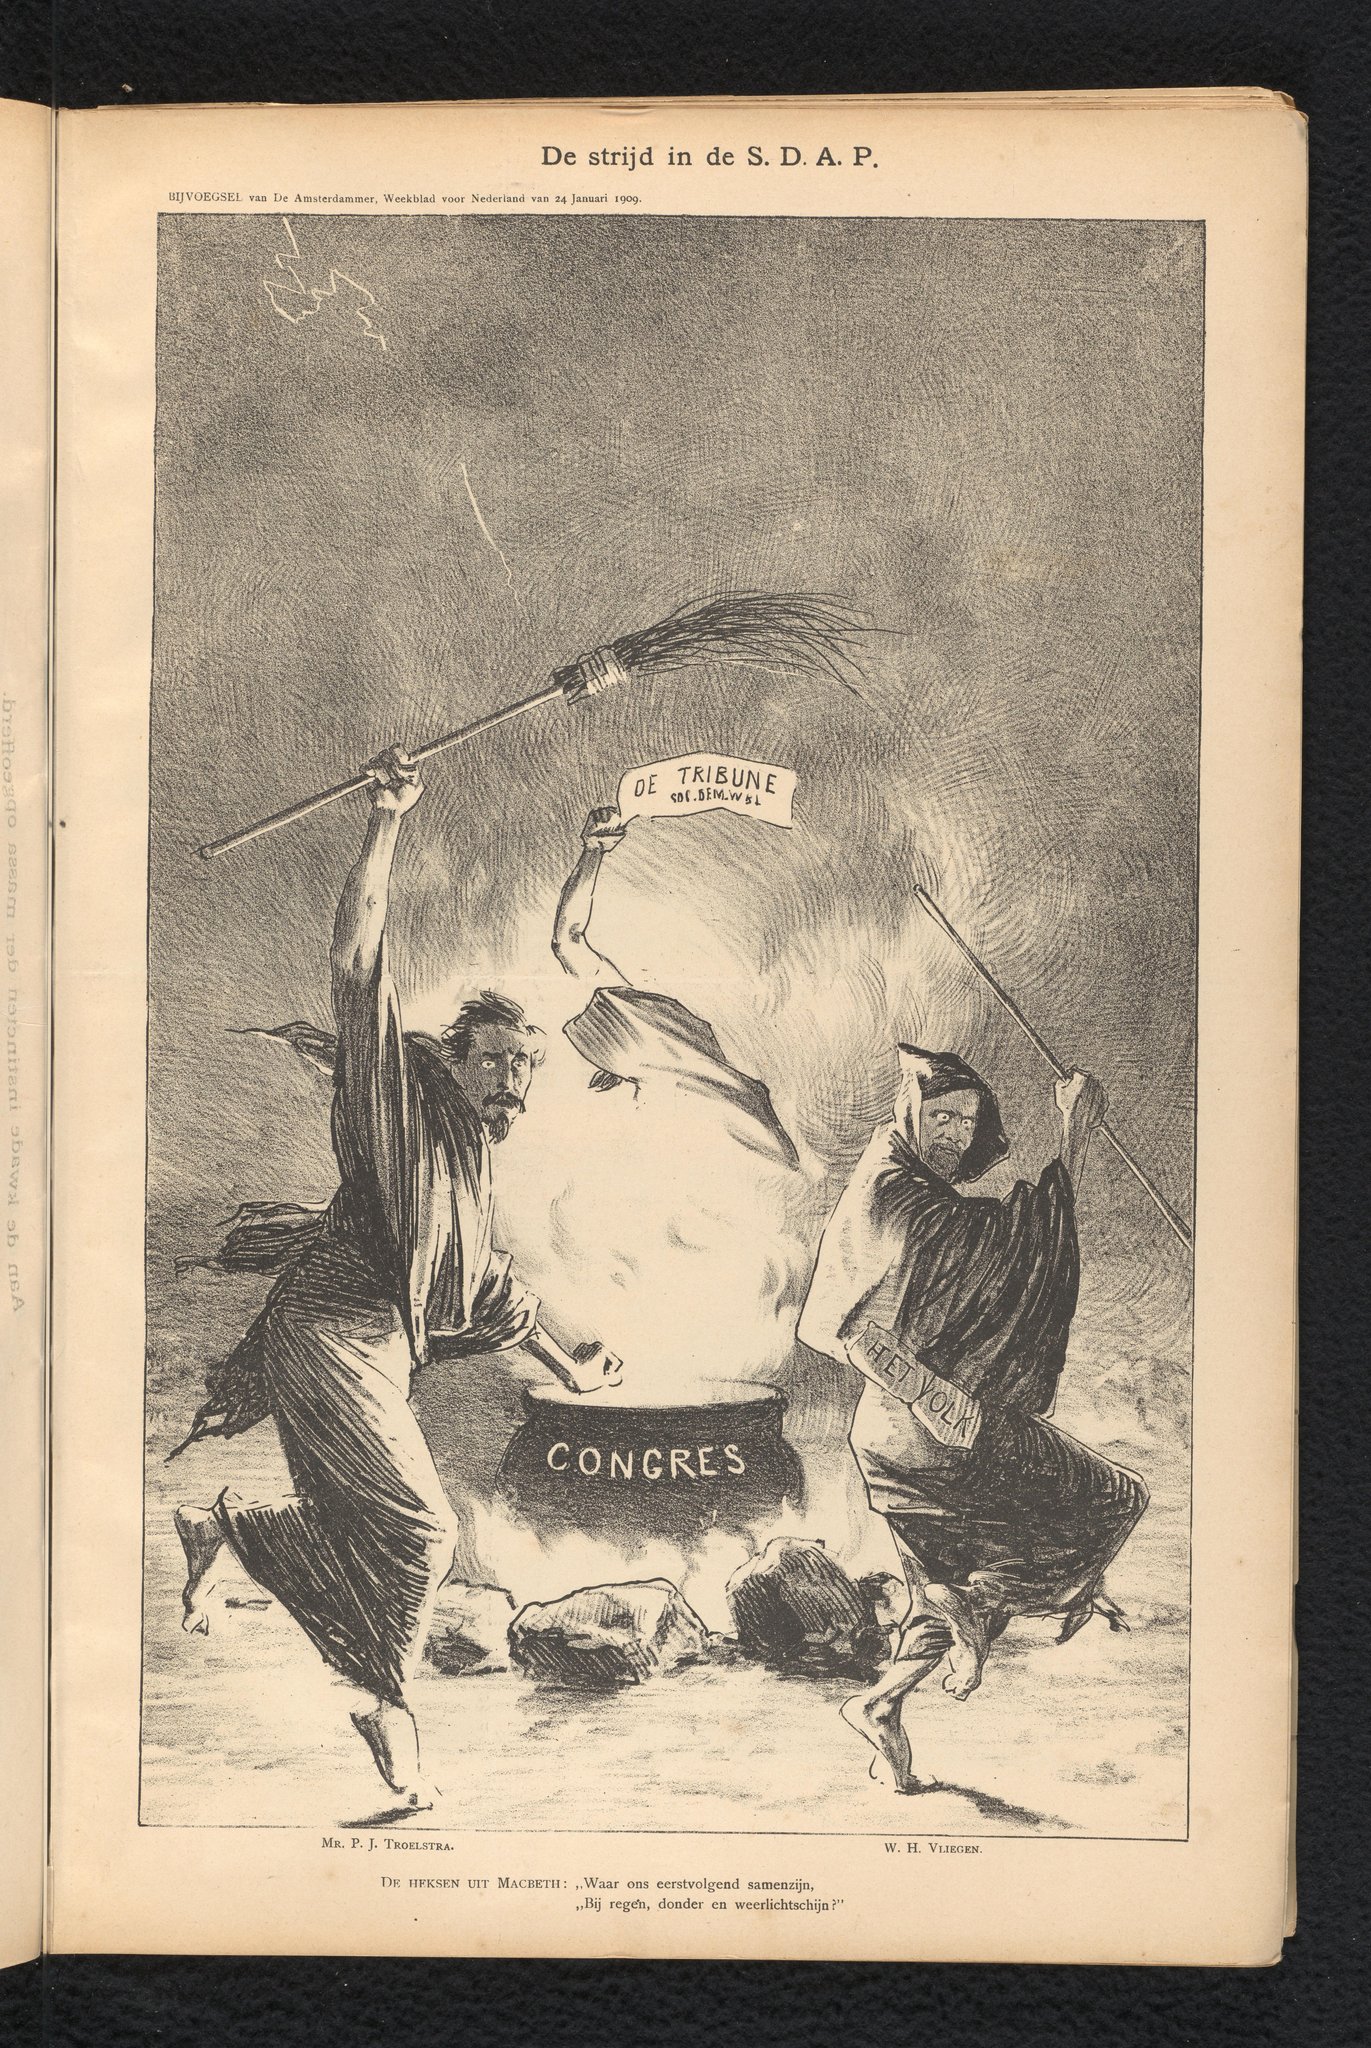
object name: cartoon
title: De strijd in de S.D.A.P.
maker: johan braakensiek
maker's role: draughtsman, print maker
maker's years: 1858-1940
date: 1909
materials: paper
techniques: lithograph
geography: amsterdam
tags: politician, (scenes from) specific works of literature (with author, title), political caricatures and satires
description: Pieter Jelles Troelstra, Willem Vliegen en het blad De Tribune dansen als de heksen uit Macbeth om de heksenketel, het congres van de SDAP.